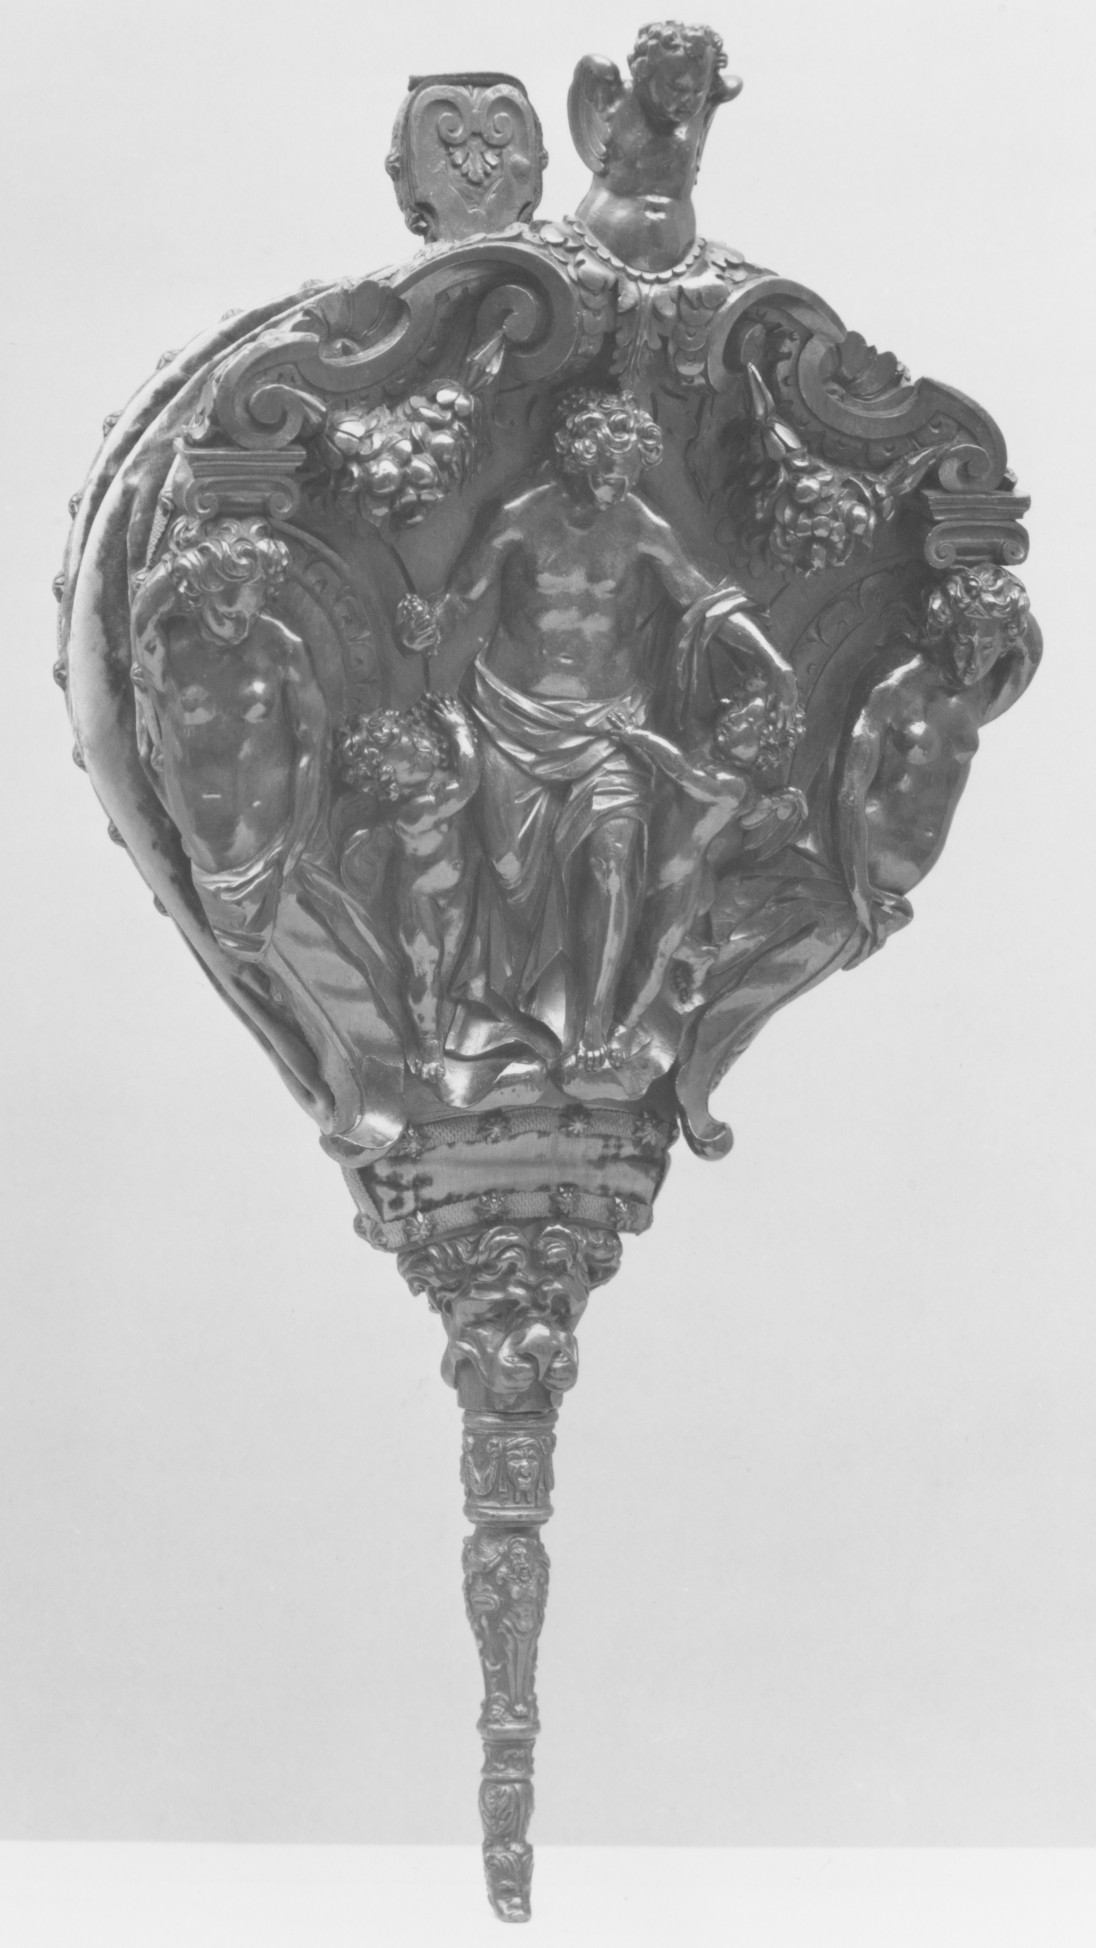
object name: bellow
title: Bellows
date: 1501-1600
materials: bronze, velvet, wood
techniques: carving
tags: women,putti